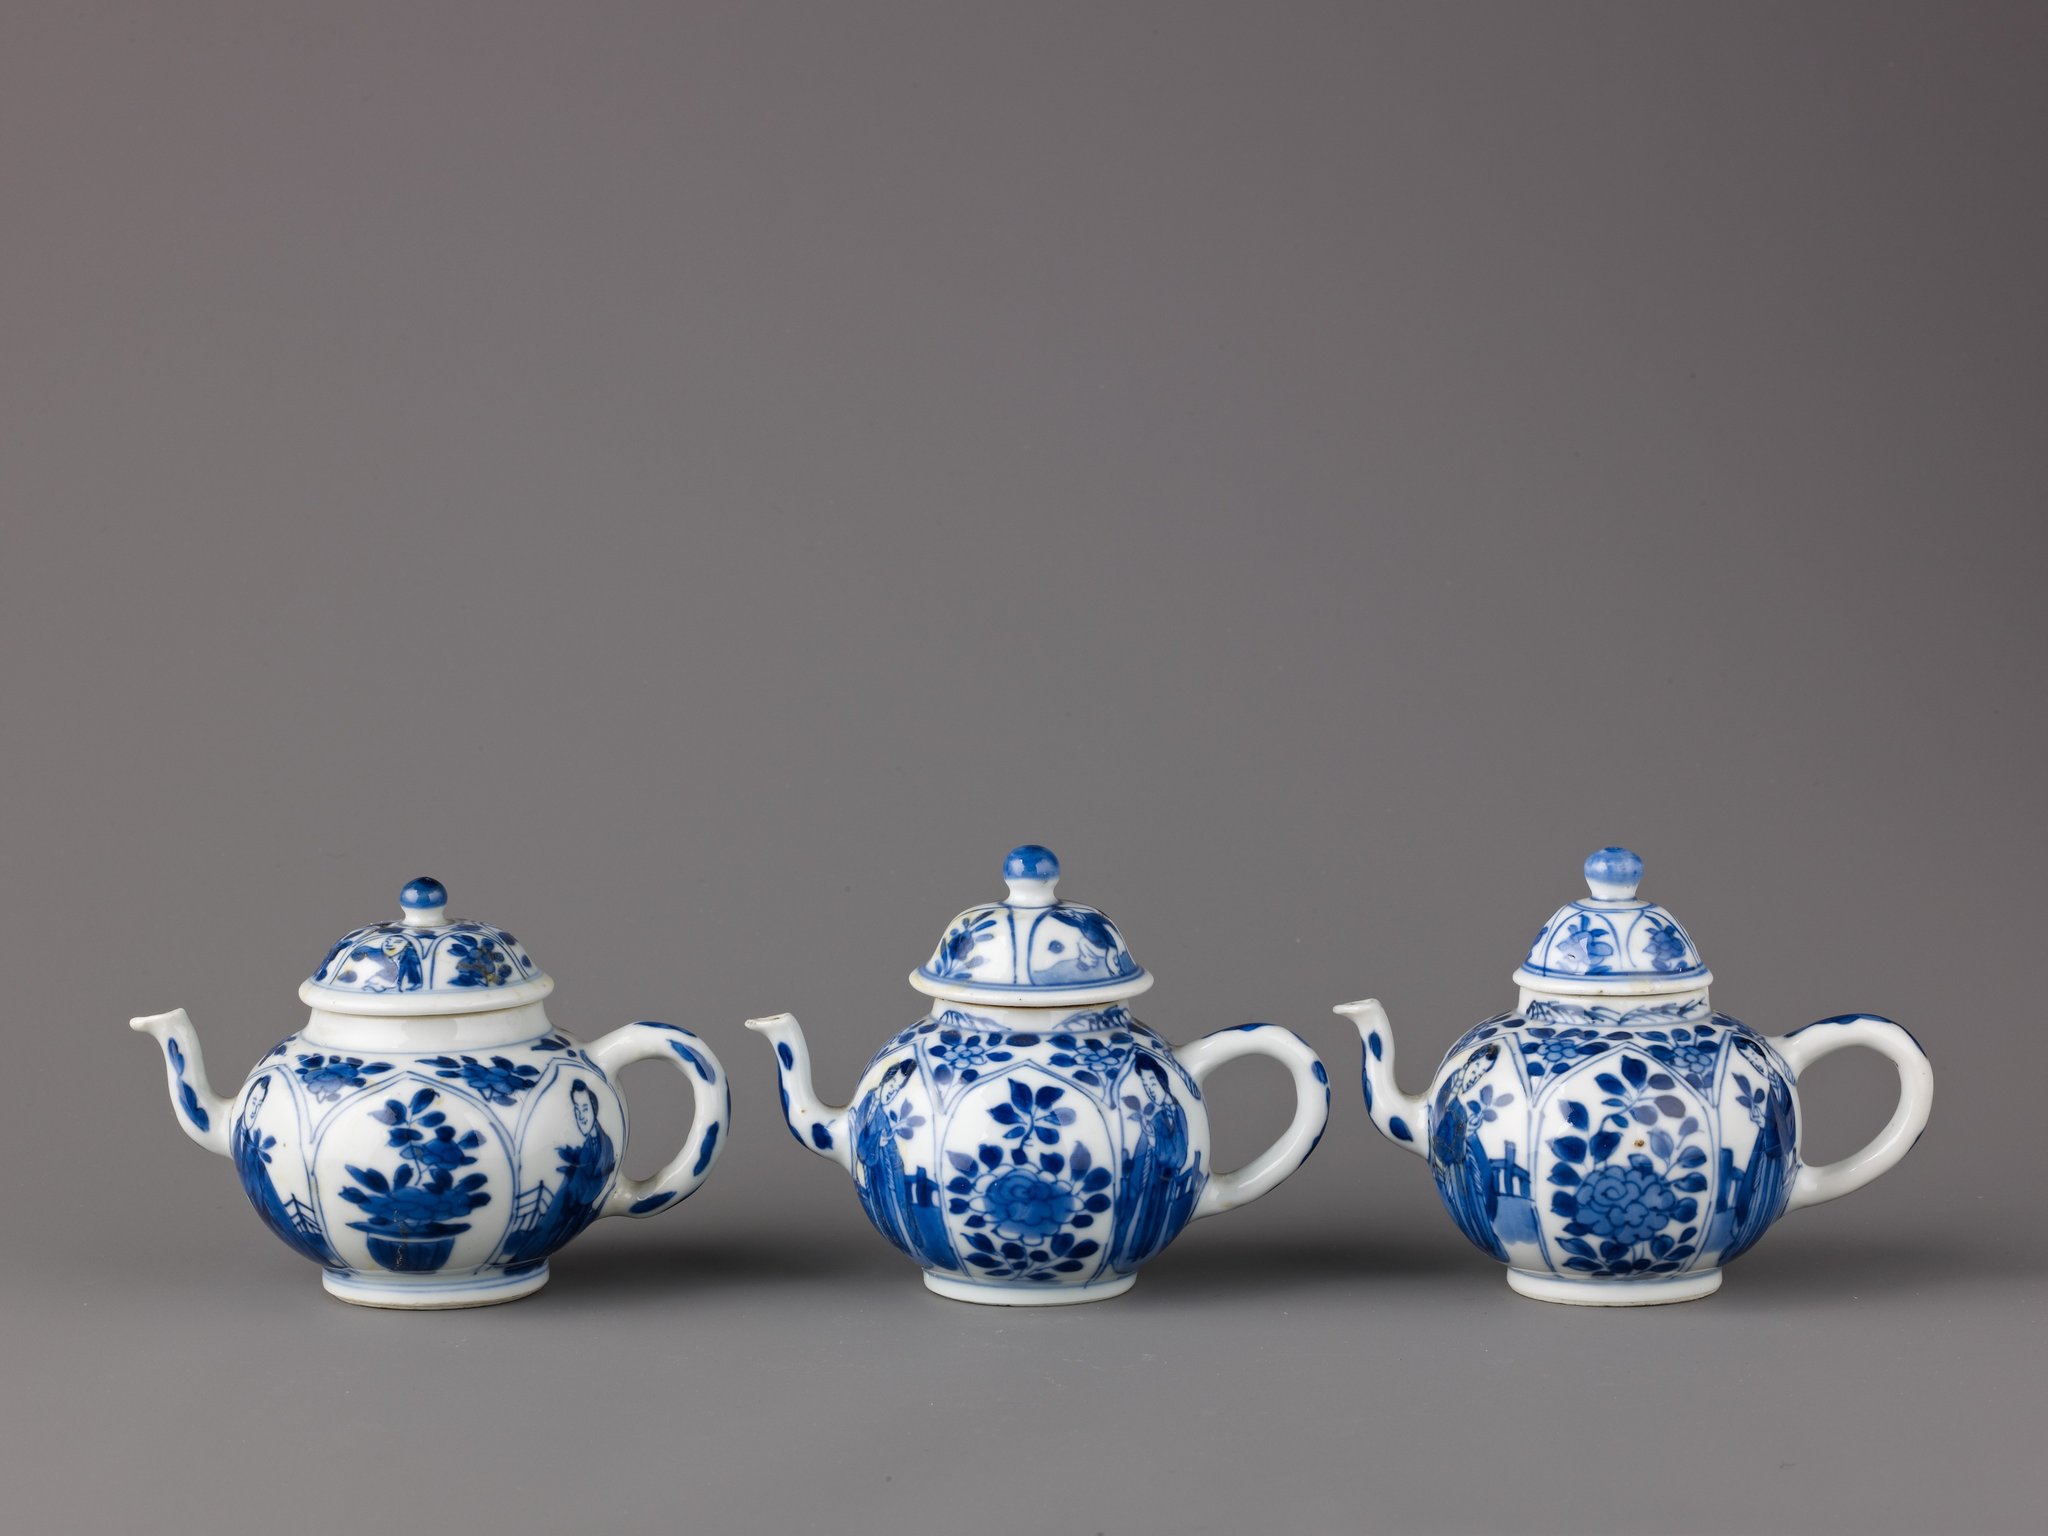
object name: covered winepot or teapot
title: Small covered winepot or teapot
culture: chinese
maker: chinese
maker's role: artist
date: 1662-1722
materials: porcelain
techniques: painting, underglaze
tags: flowers